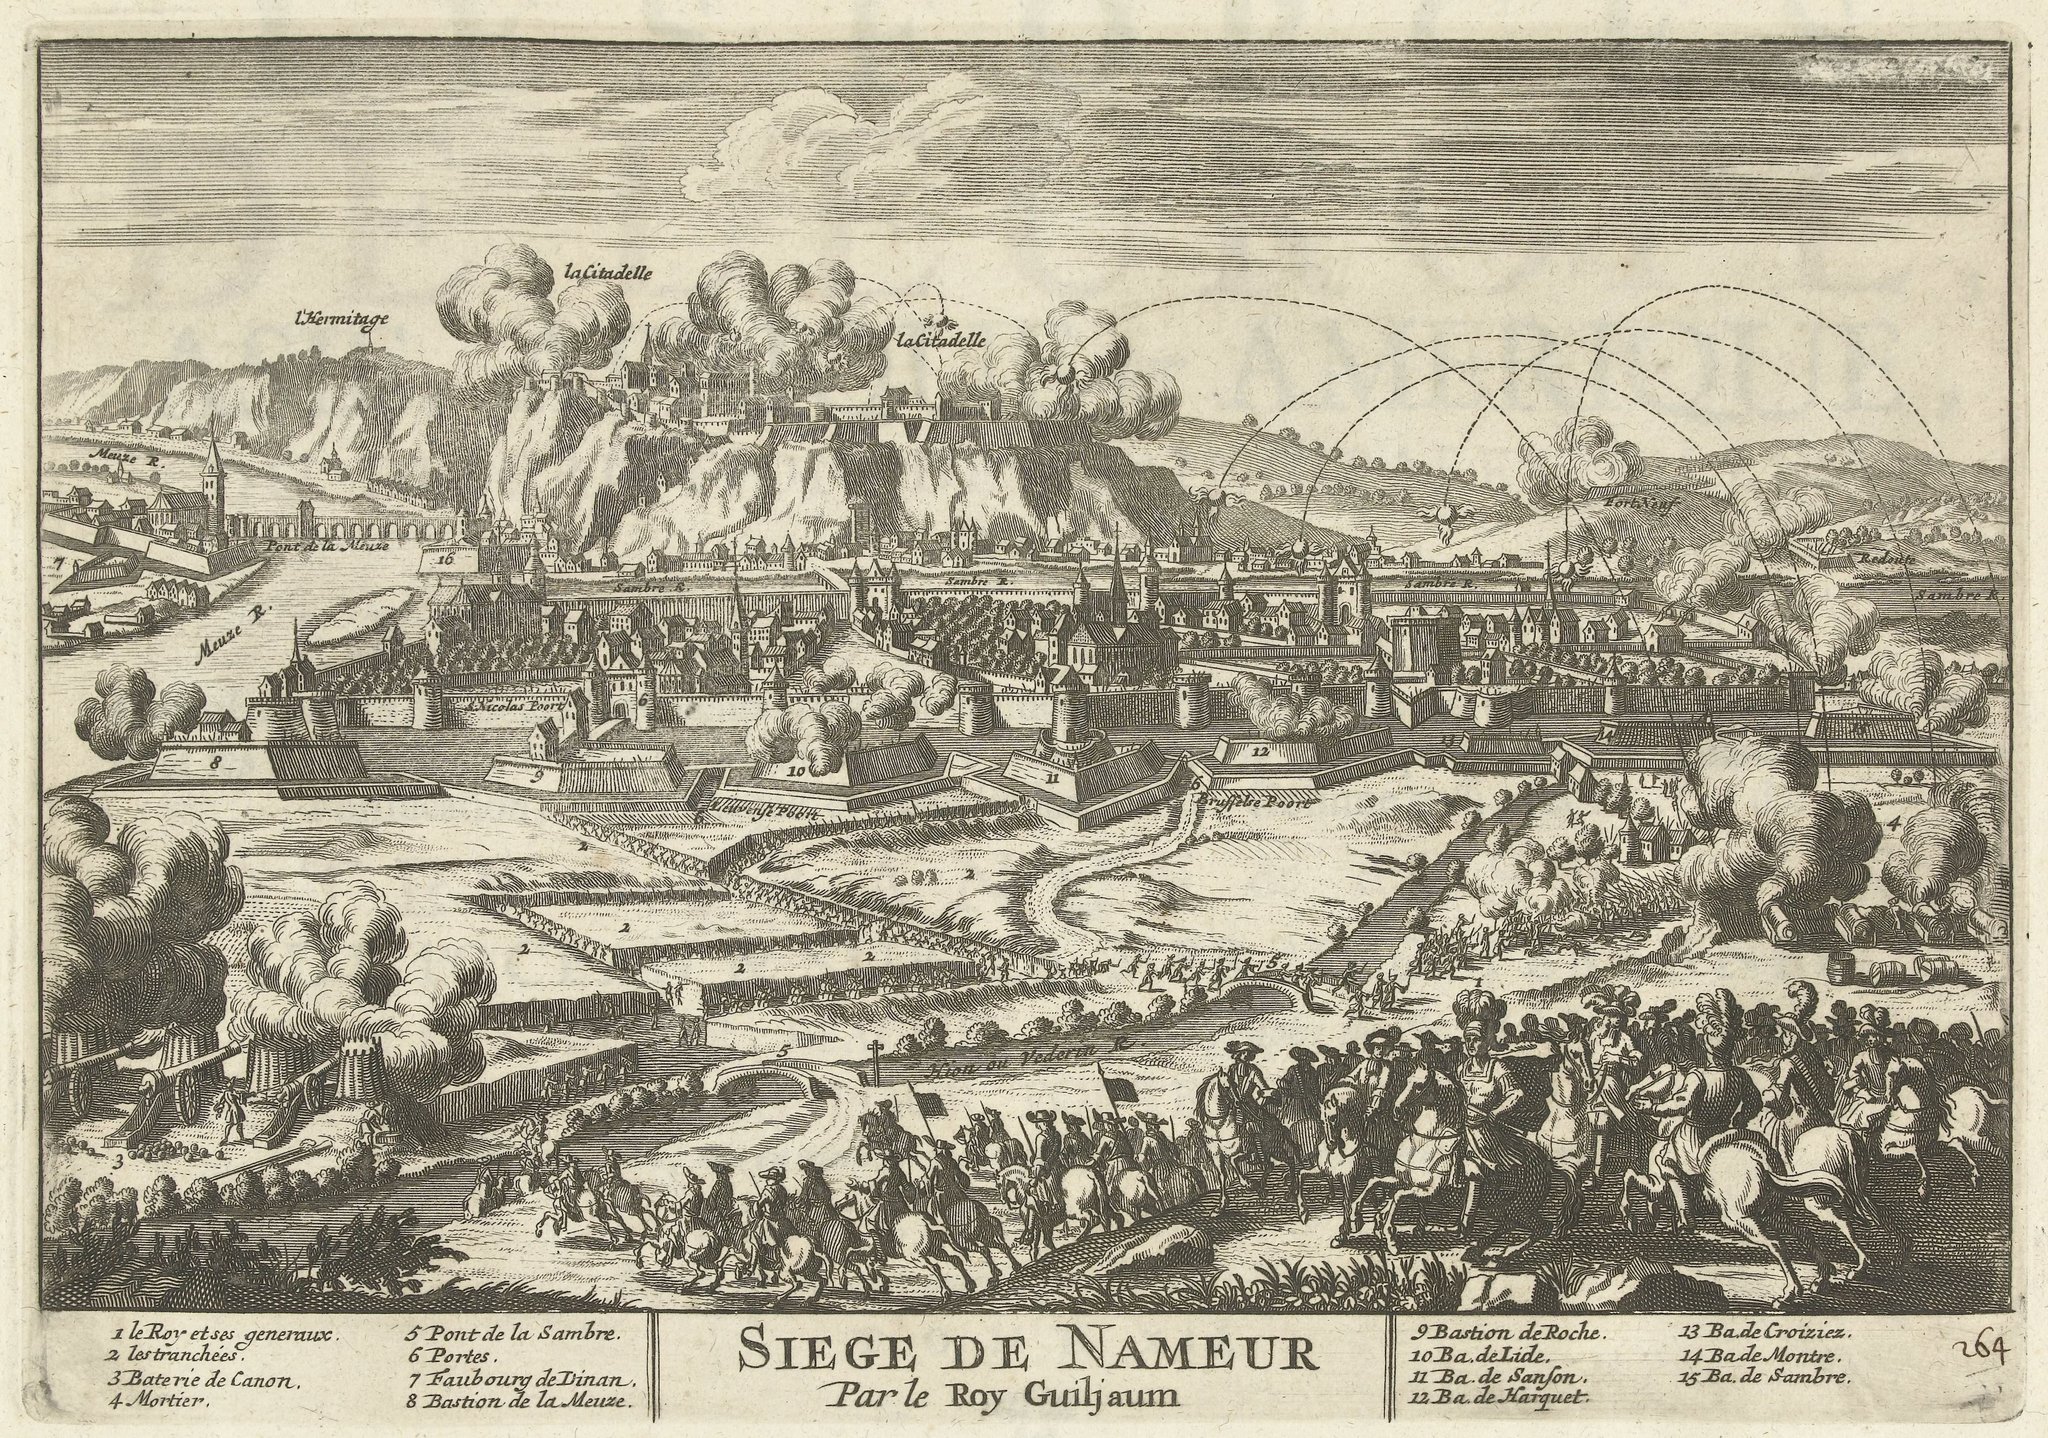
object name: history print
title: Siege de Nameur Par le Roy Guiljaum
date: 1726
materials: paper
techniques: etching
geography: paris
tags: the hague, william iii (prince of orange and king of england, scotland, and ireland), siege, position war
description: Het beleg van Namen door de geallieerden onder Willem III in 1695. De voorstelling toont de beschieting van Namen met op de voorgrond oprukkende cavalerie. Verschillende details in de voorstelling zijn met de cijfers 1-15 aangeduid en worden onderaan verklaard. In de rechter bovenhoek is een opschrift in de plaat (Tom. 3 Pag 288) gedeeltelijk verwijderd. Plaat nr. 264 in deel XI van het prentwerk: Les Forces de l'Europe, Asie, Afrique et Amerique ... Comme aussi les Cartes des Côtes de France et d'Espagne uit 1726, dit tweede deel met 271 met de hand genummerde platen van vermaarde sterke steden en vestingen in het kader van de Spaanse Successieoorlog 1701-1713. Voor het merendeel zijn deze platen gekopieerd naar de anonieme Franse platen van vermaarde sterke steden en vestingen: in Les forces de l'Europe en in: Le theatre de la guerre, dans les Pays-Bas, beide oorspronkelijk uitgegeven door Nicolas de Fer te Parijs (1693-1697) in het kader van de Negenjarige Oorlog. Titel en opschriften in het Frans.